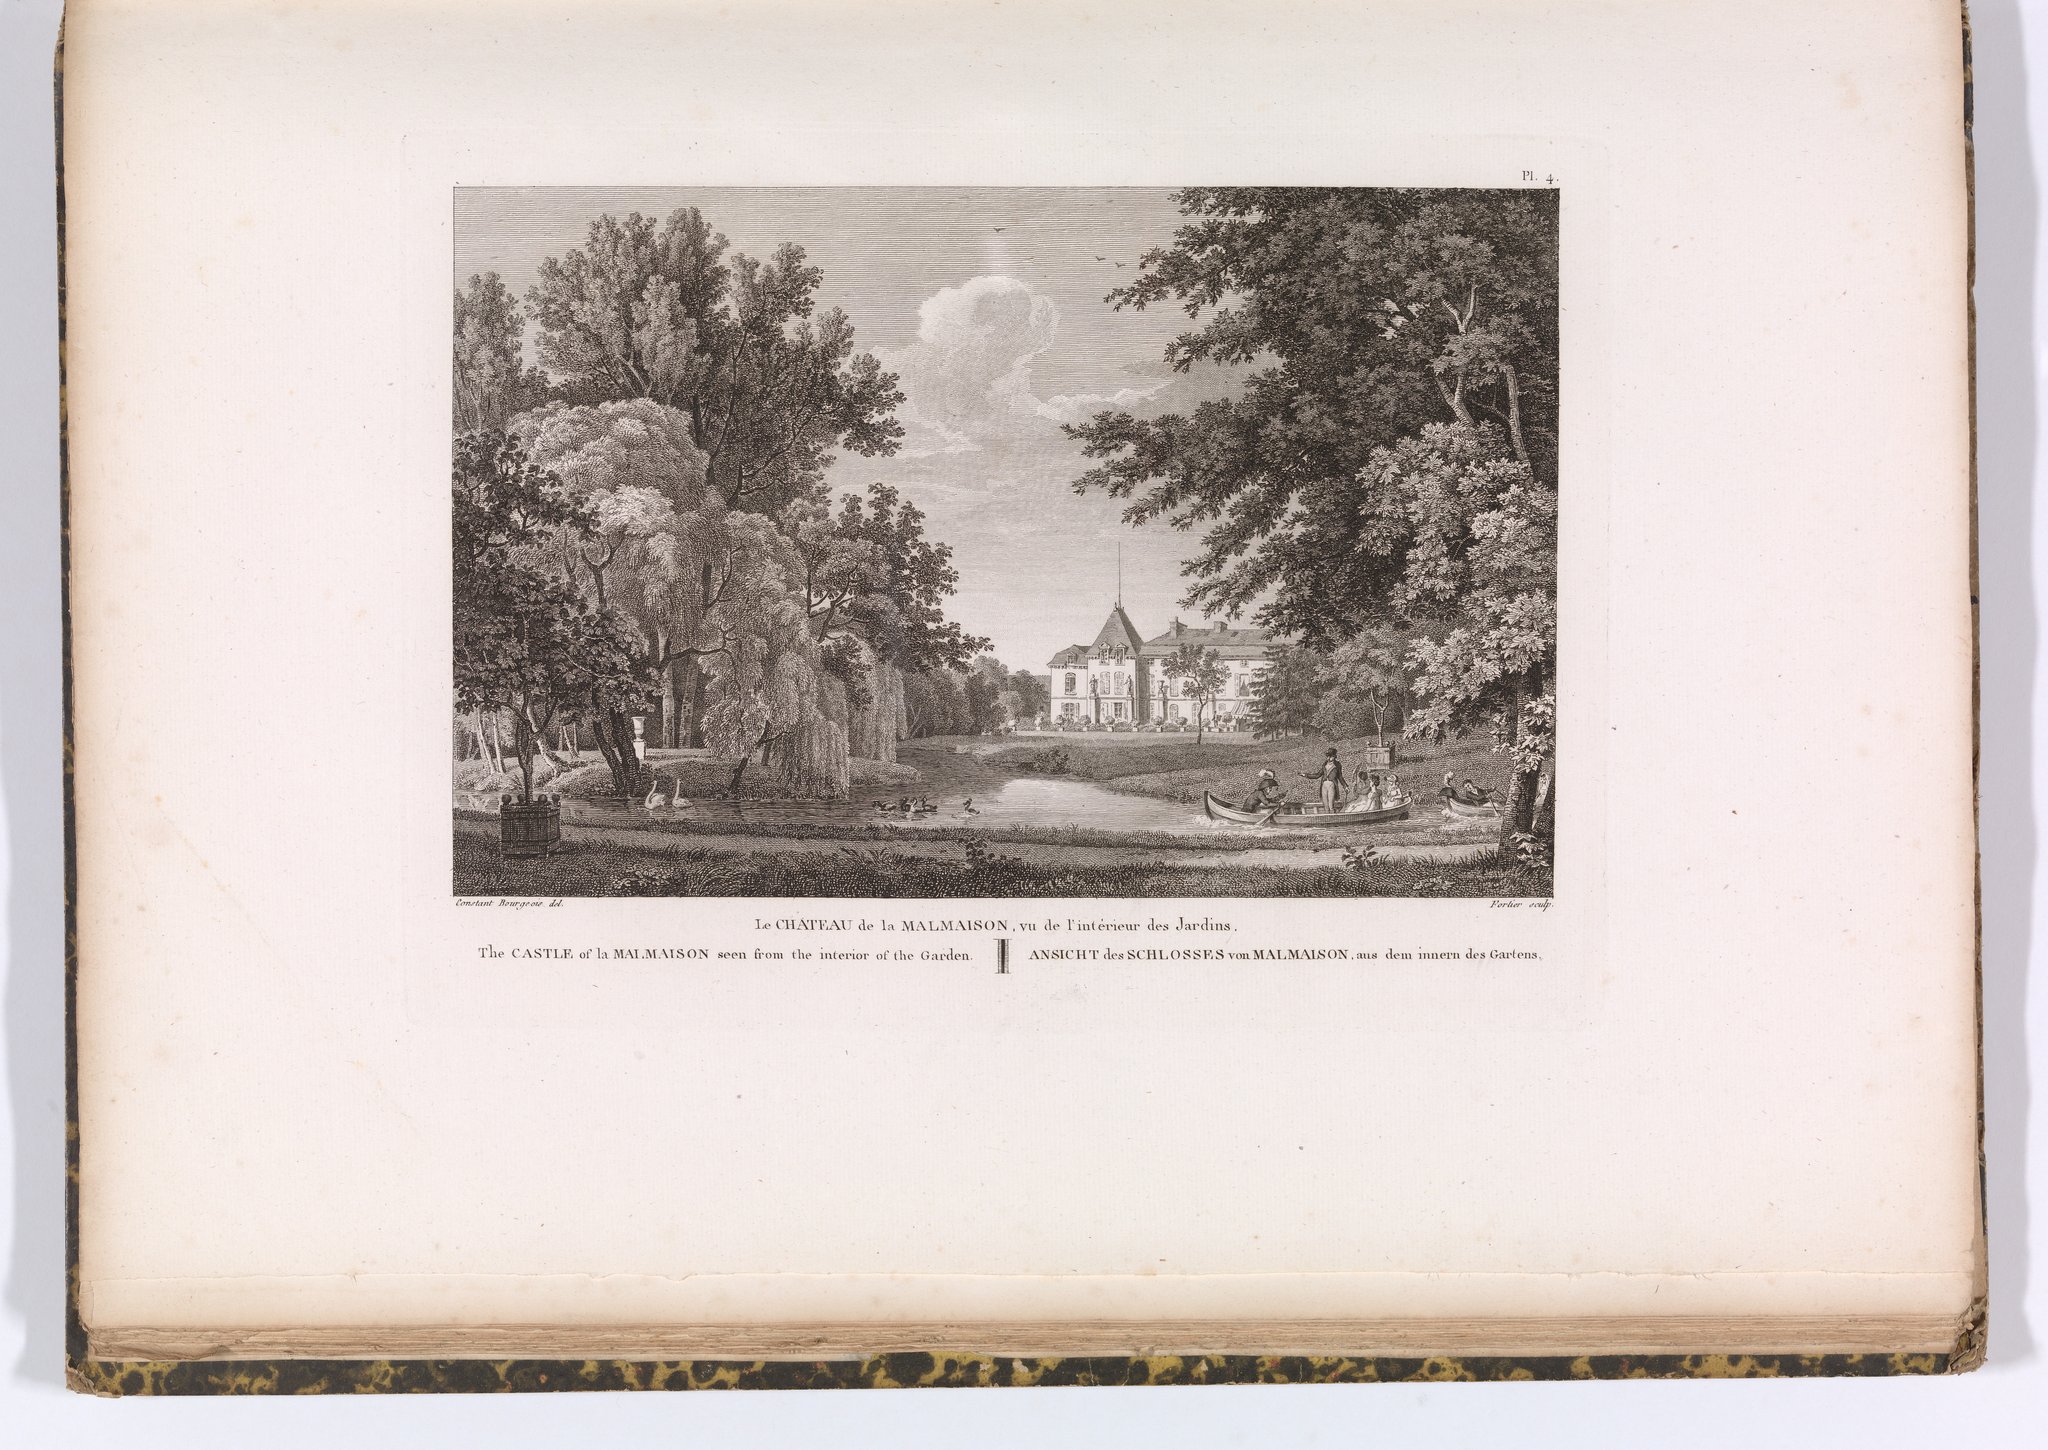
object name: book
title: Description des Nouveaux Jardins de la France et ses Anciens Chateaux...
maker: alexandre de laborde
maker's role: author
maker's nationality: french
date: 1808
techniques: engraving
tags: buildings,gardens,men,women,boats